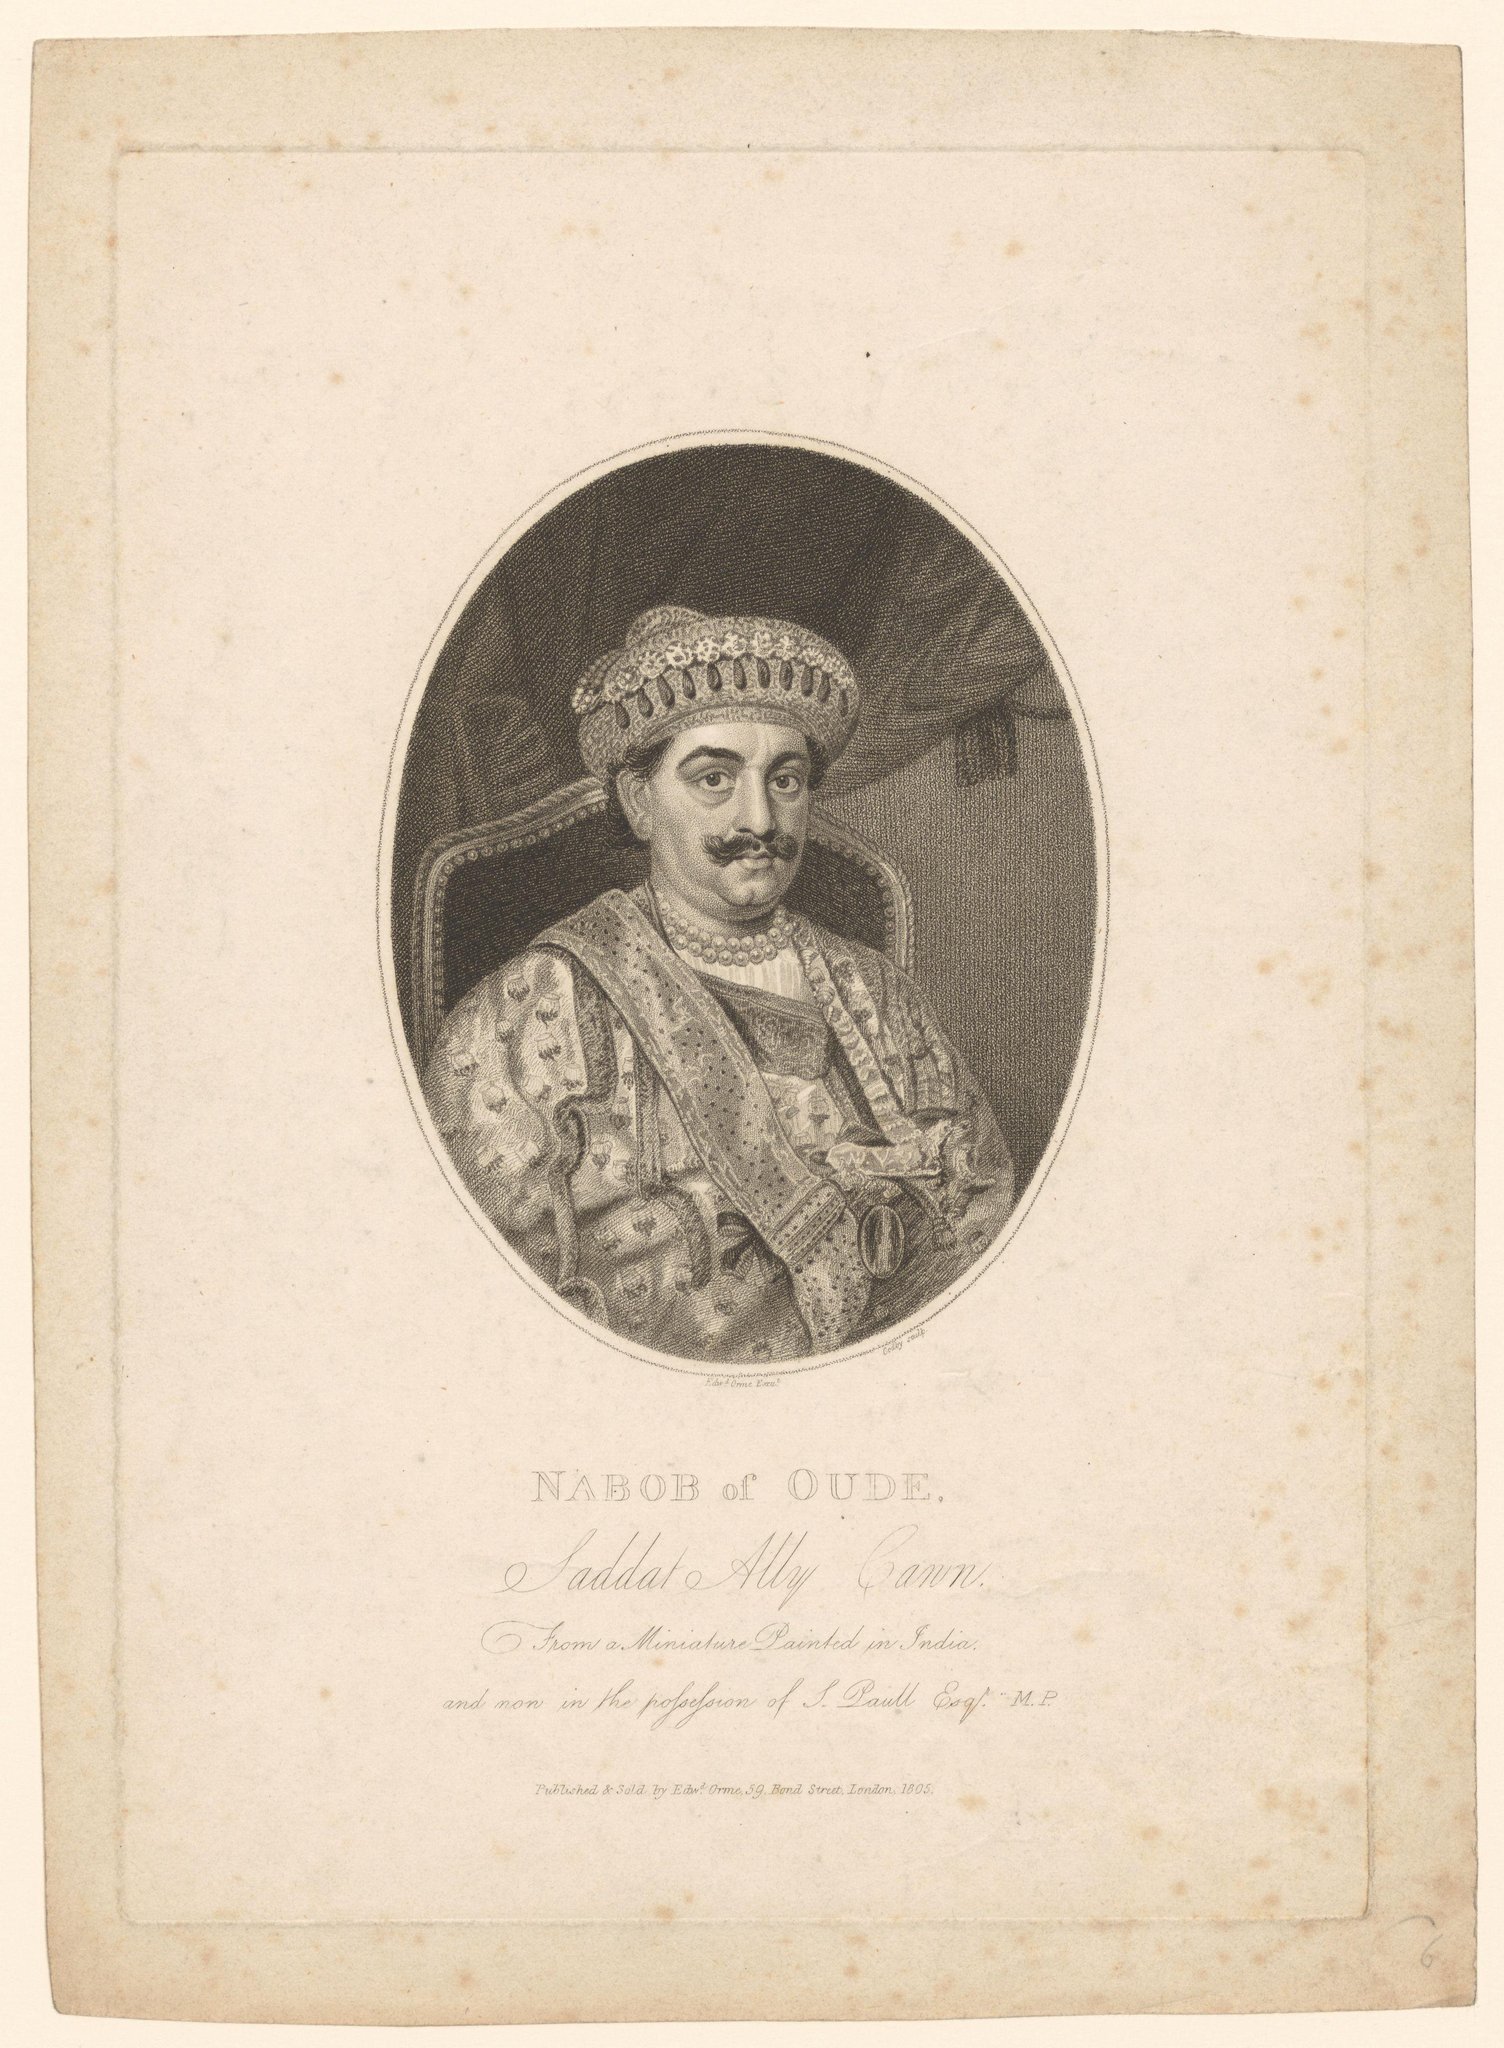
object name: print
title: Portret van Saadat Ali Khan I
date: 1805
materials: paper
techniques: stippling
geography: london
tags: historical persons, ruler, sovereign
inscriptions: collector's mark: Lugt 2228